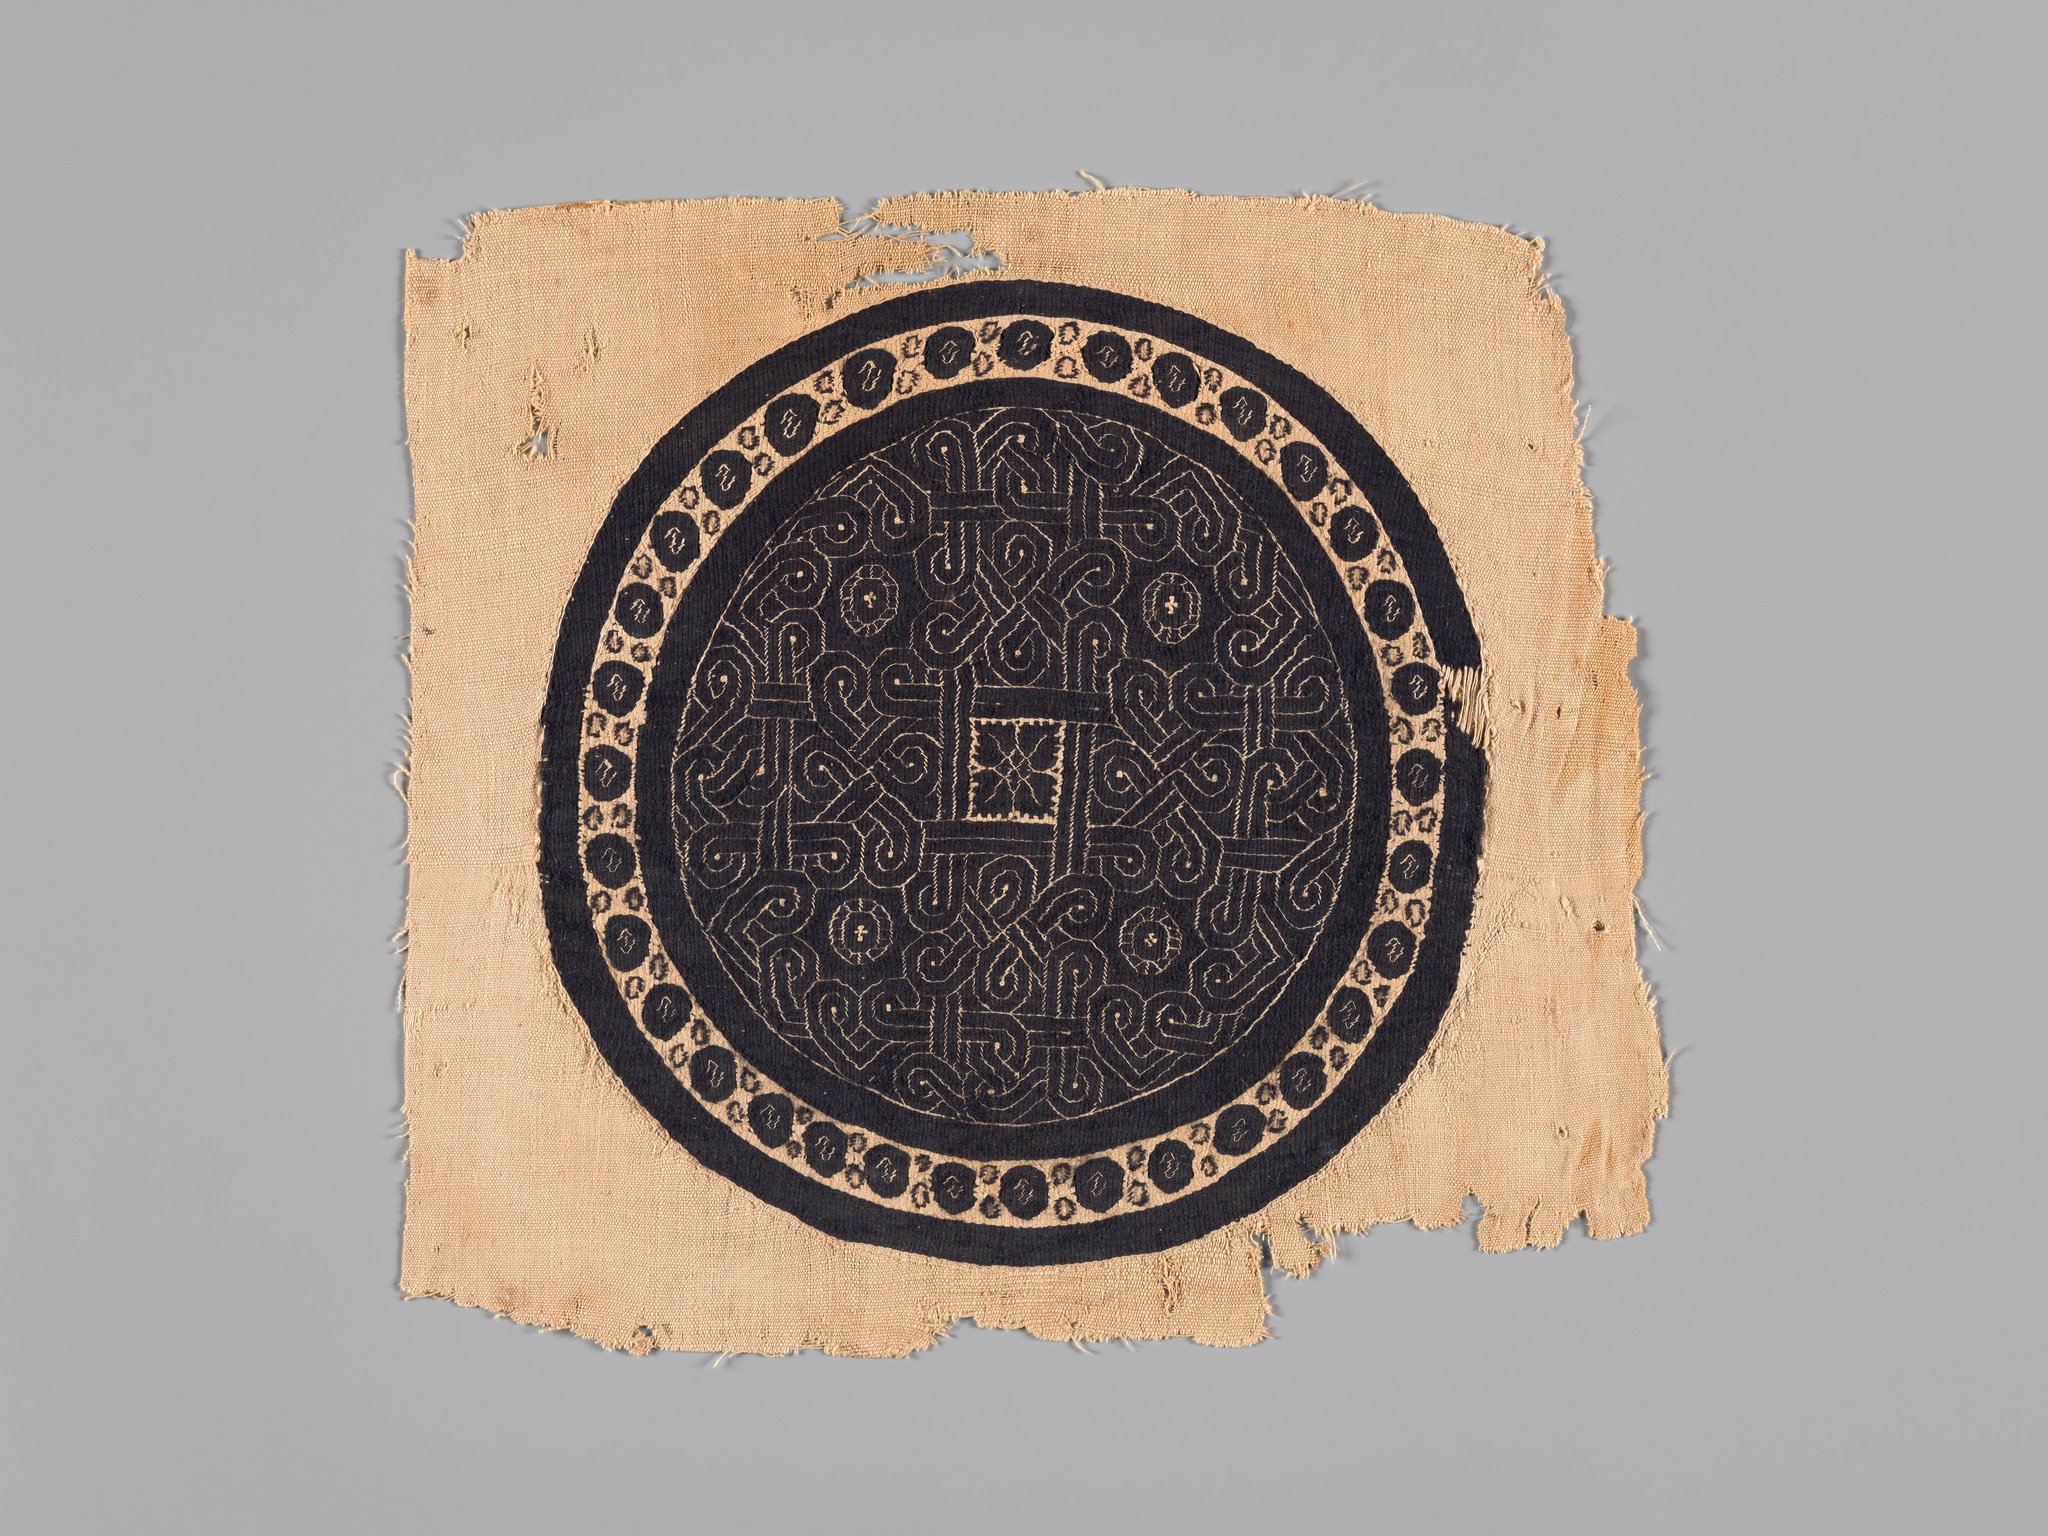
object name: textile fragment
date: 201-400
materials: linen, wool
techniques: weave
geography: egypt